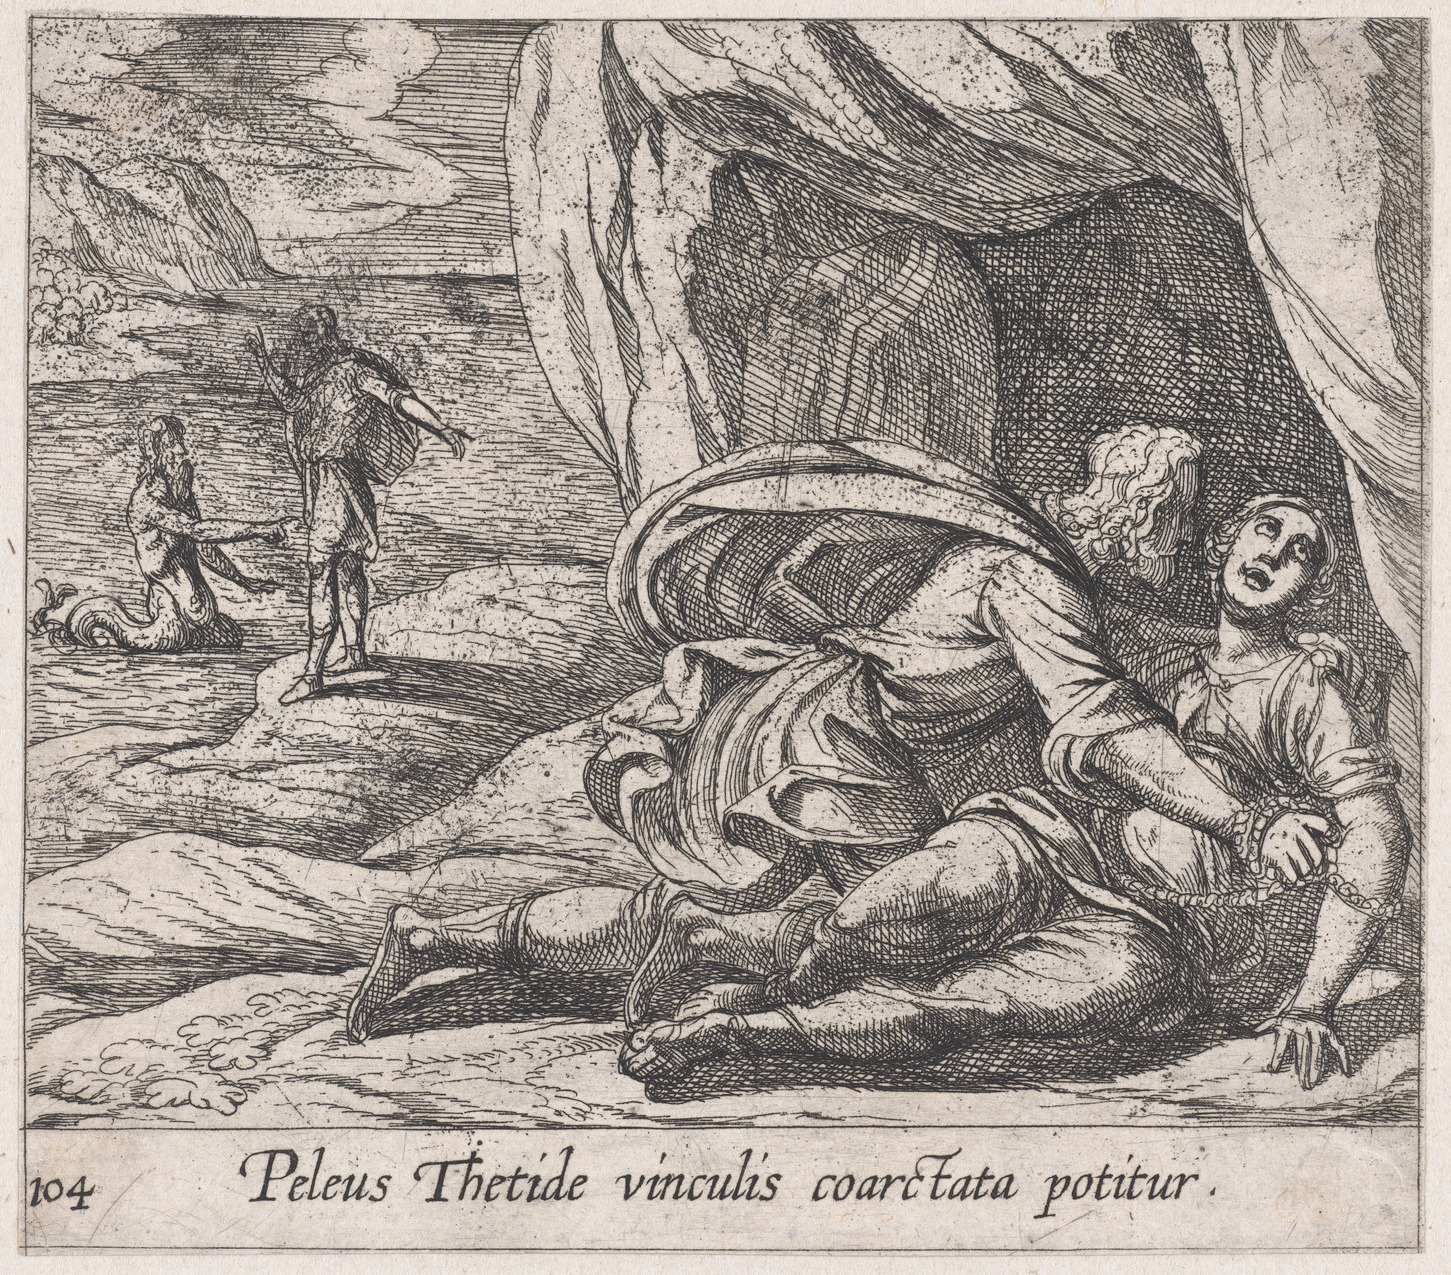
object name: print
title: Plate 104: Peleus Embracing Thetis (Peleus Thetide vinculis coarctata potitur), from Ovid's 'Metamorphoses'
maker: antonio tempesta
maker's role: artist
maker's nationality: italian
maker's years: 1555-1630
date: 1606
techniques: etching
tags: men,women,nymphs